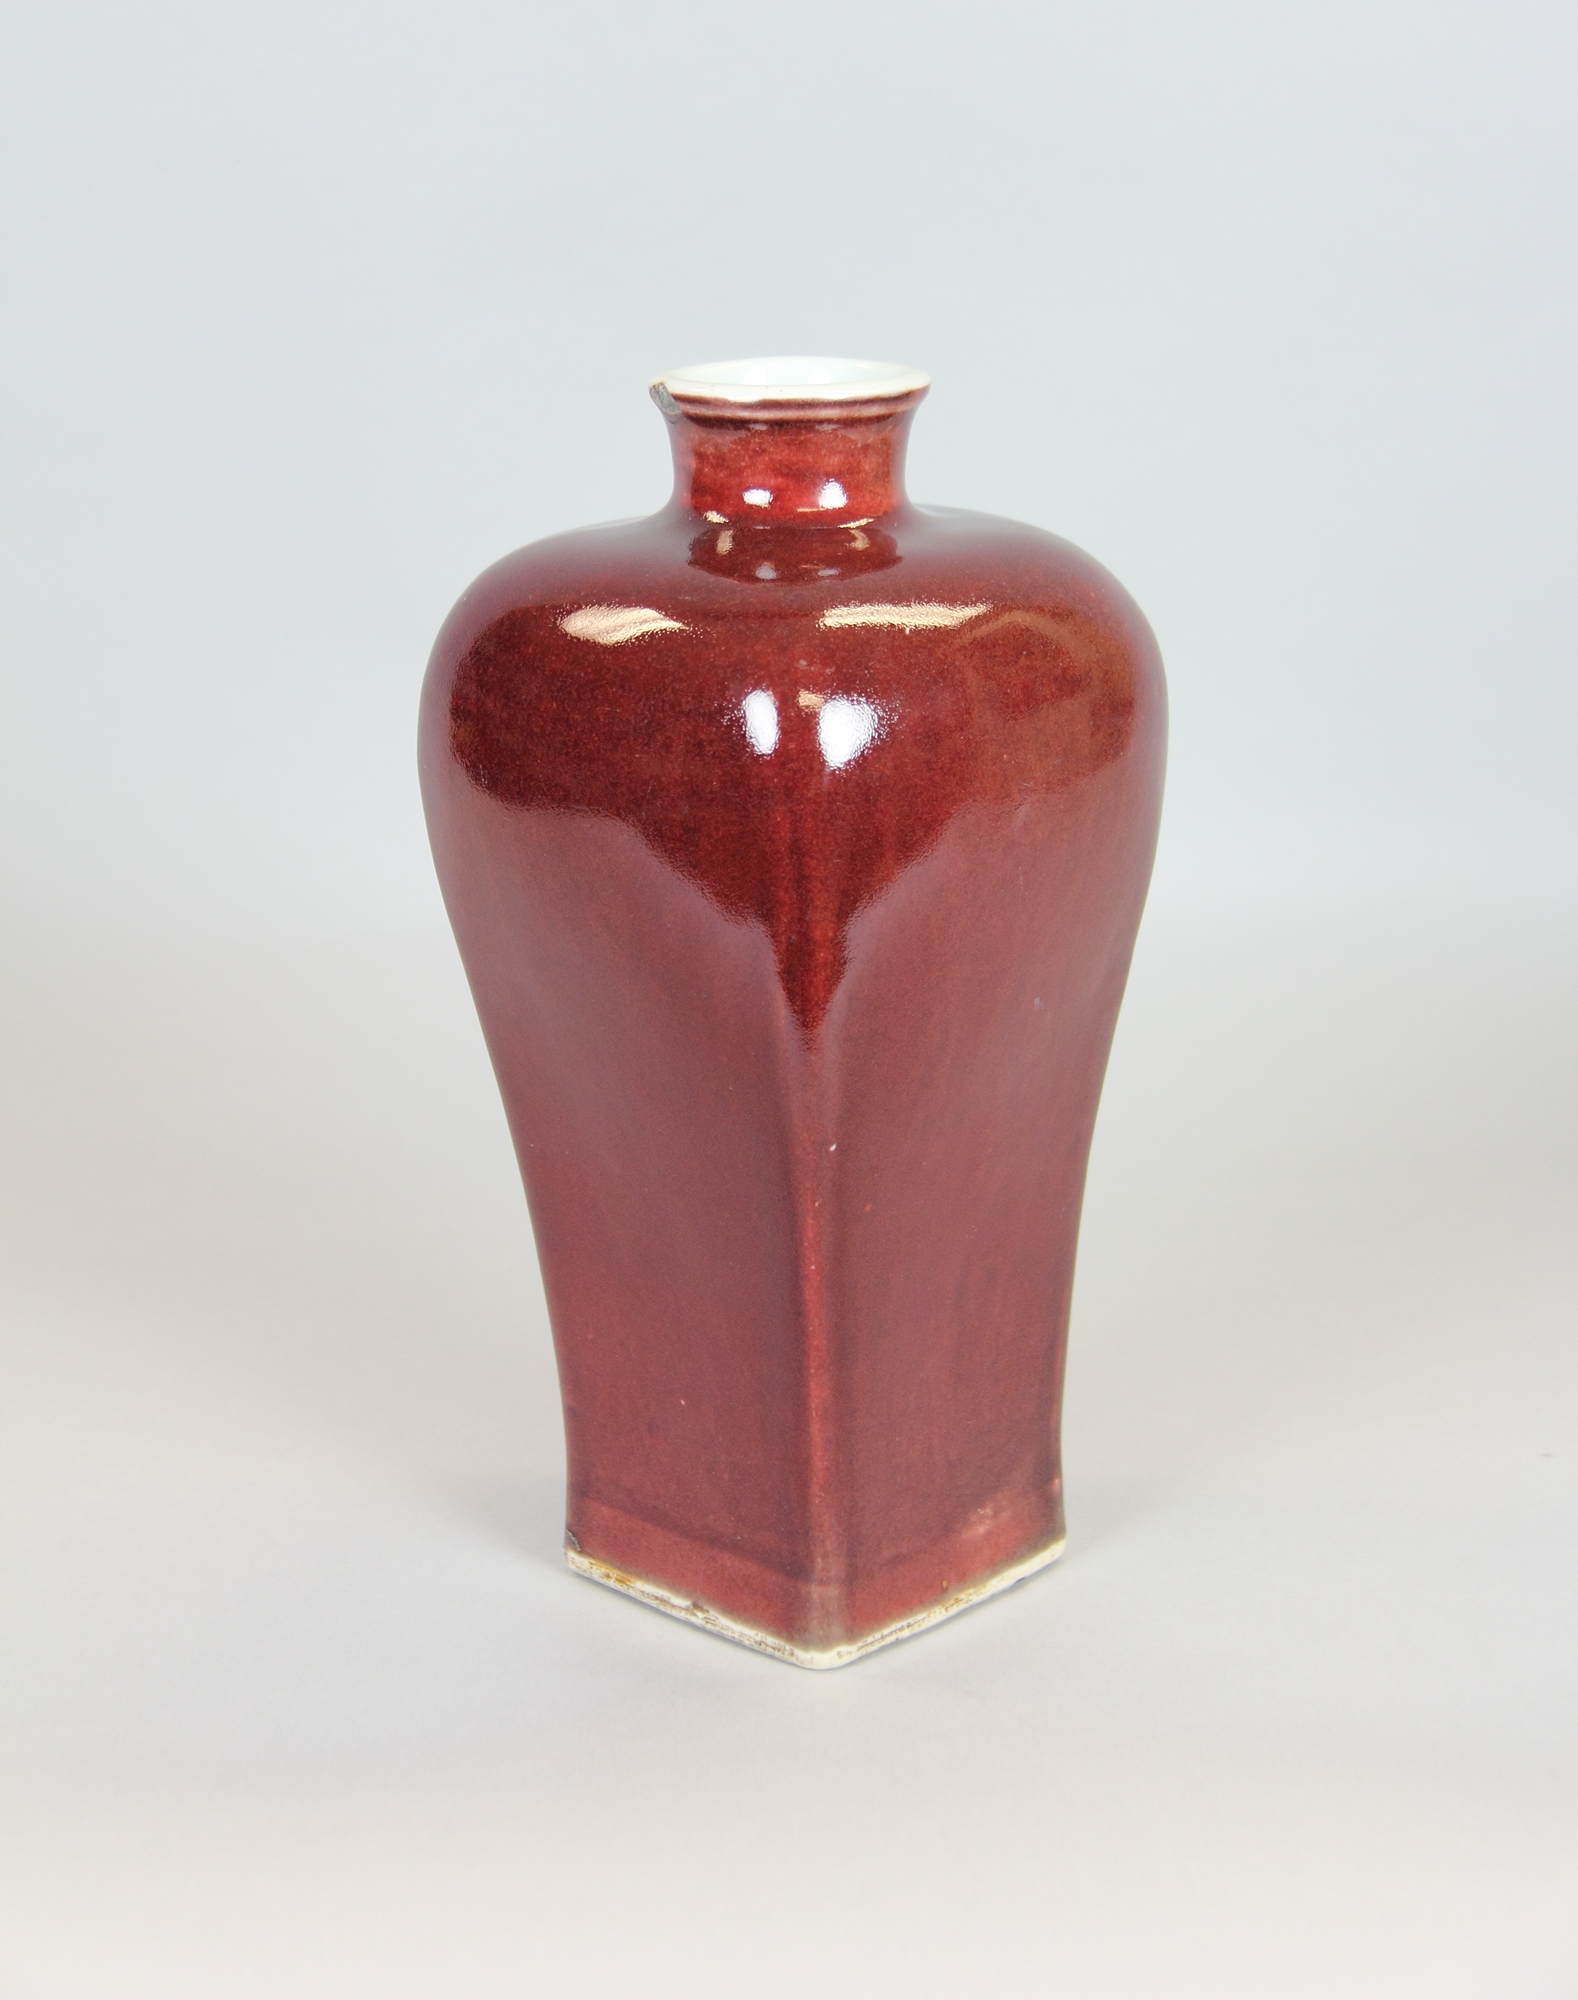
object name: vase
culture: chinese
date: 1767-1833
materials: copper, glaze, porcelain